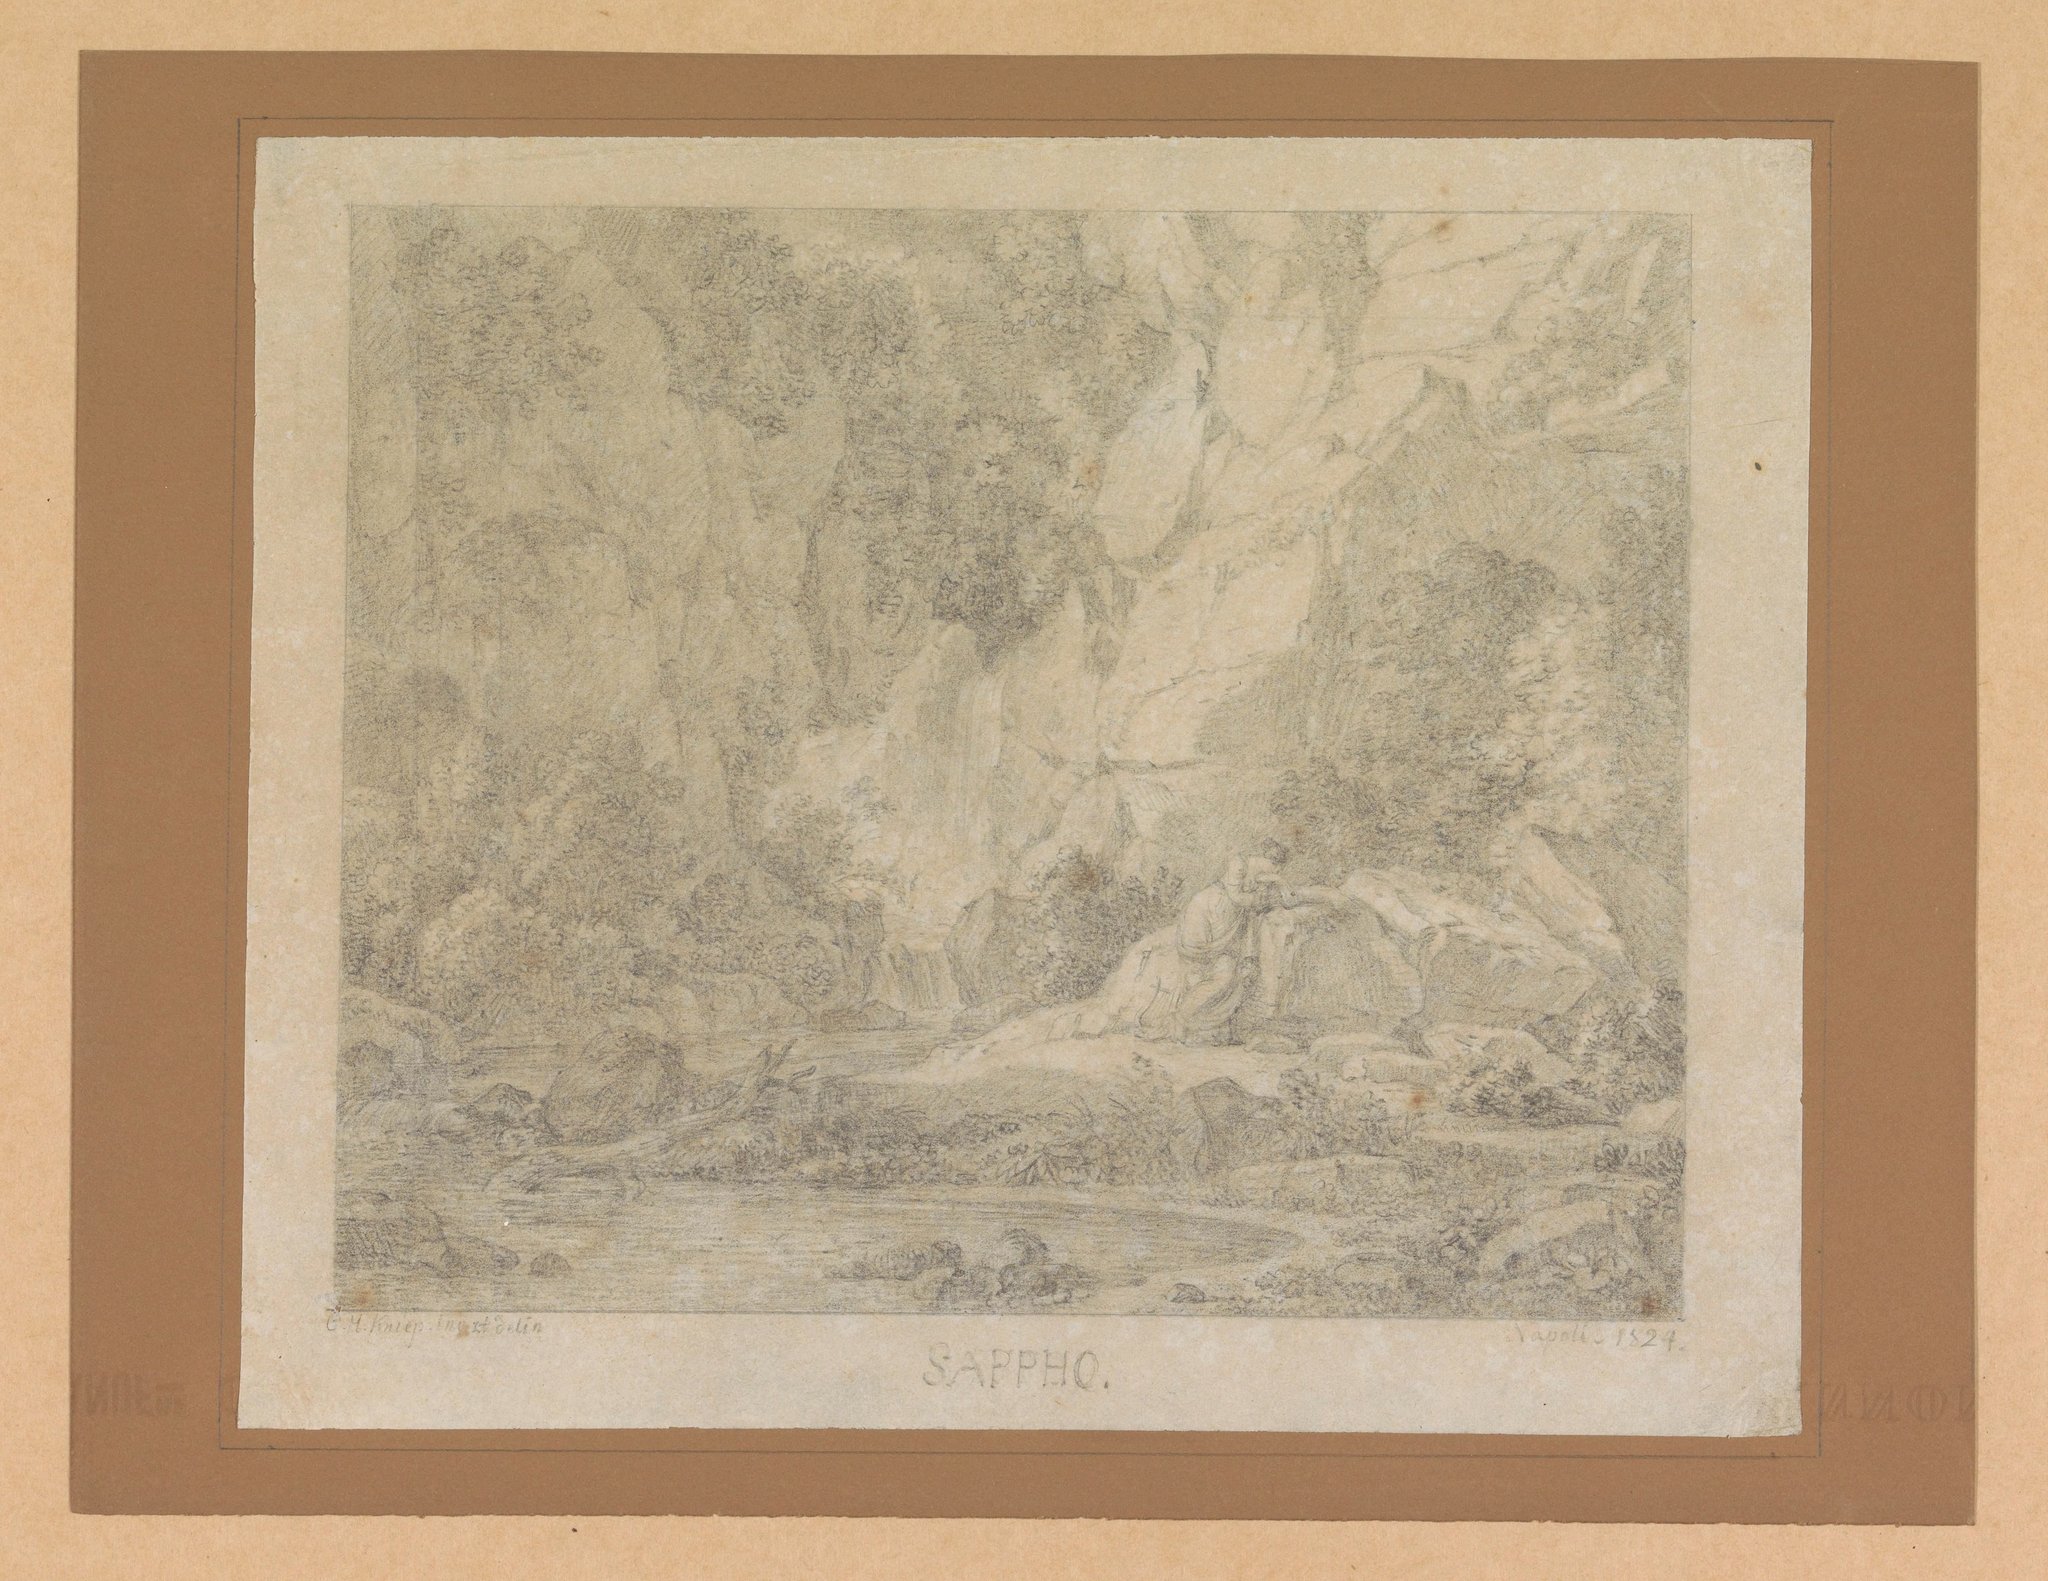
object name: drawing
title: Sappho bij een meer in een berglandschap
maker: christoph heinrich kniep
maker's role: draughtsman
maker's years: 1755-1825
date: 1824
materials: chalk, paper, pencil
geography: naples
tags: (story of) sappho, the poetess, lake, mountains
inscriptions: collector's mark: Lugt 2228, inscription: ‘Sappho.’, inscription: ‘Napoli 1824.’